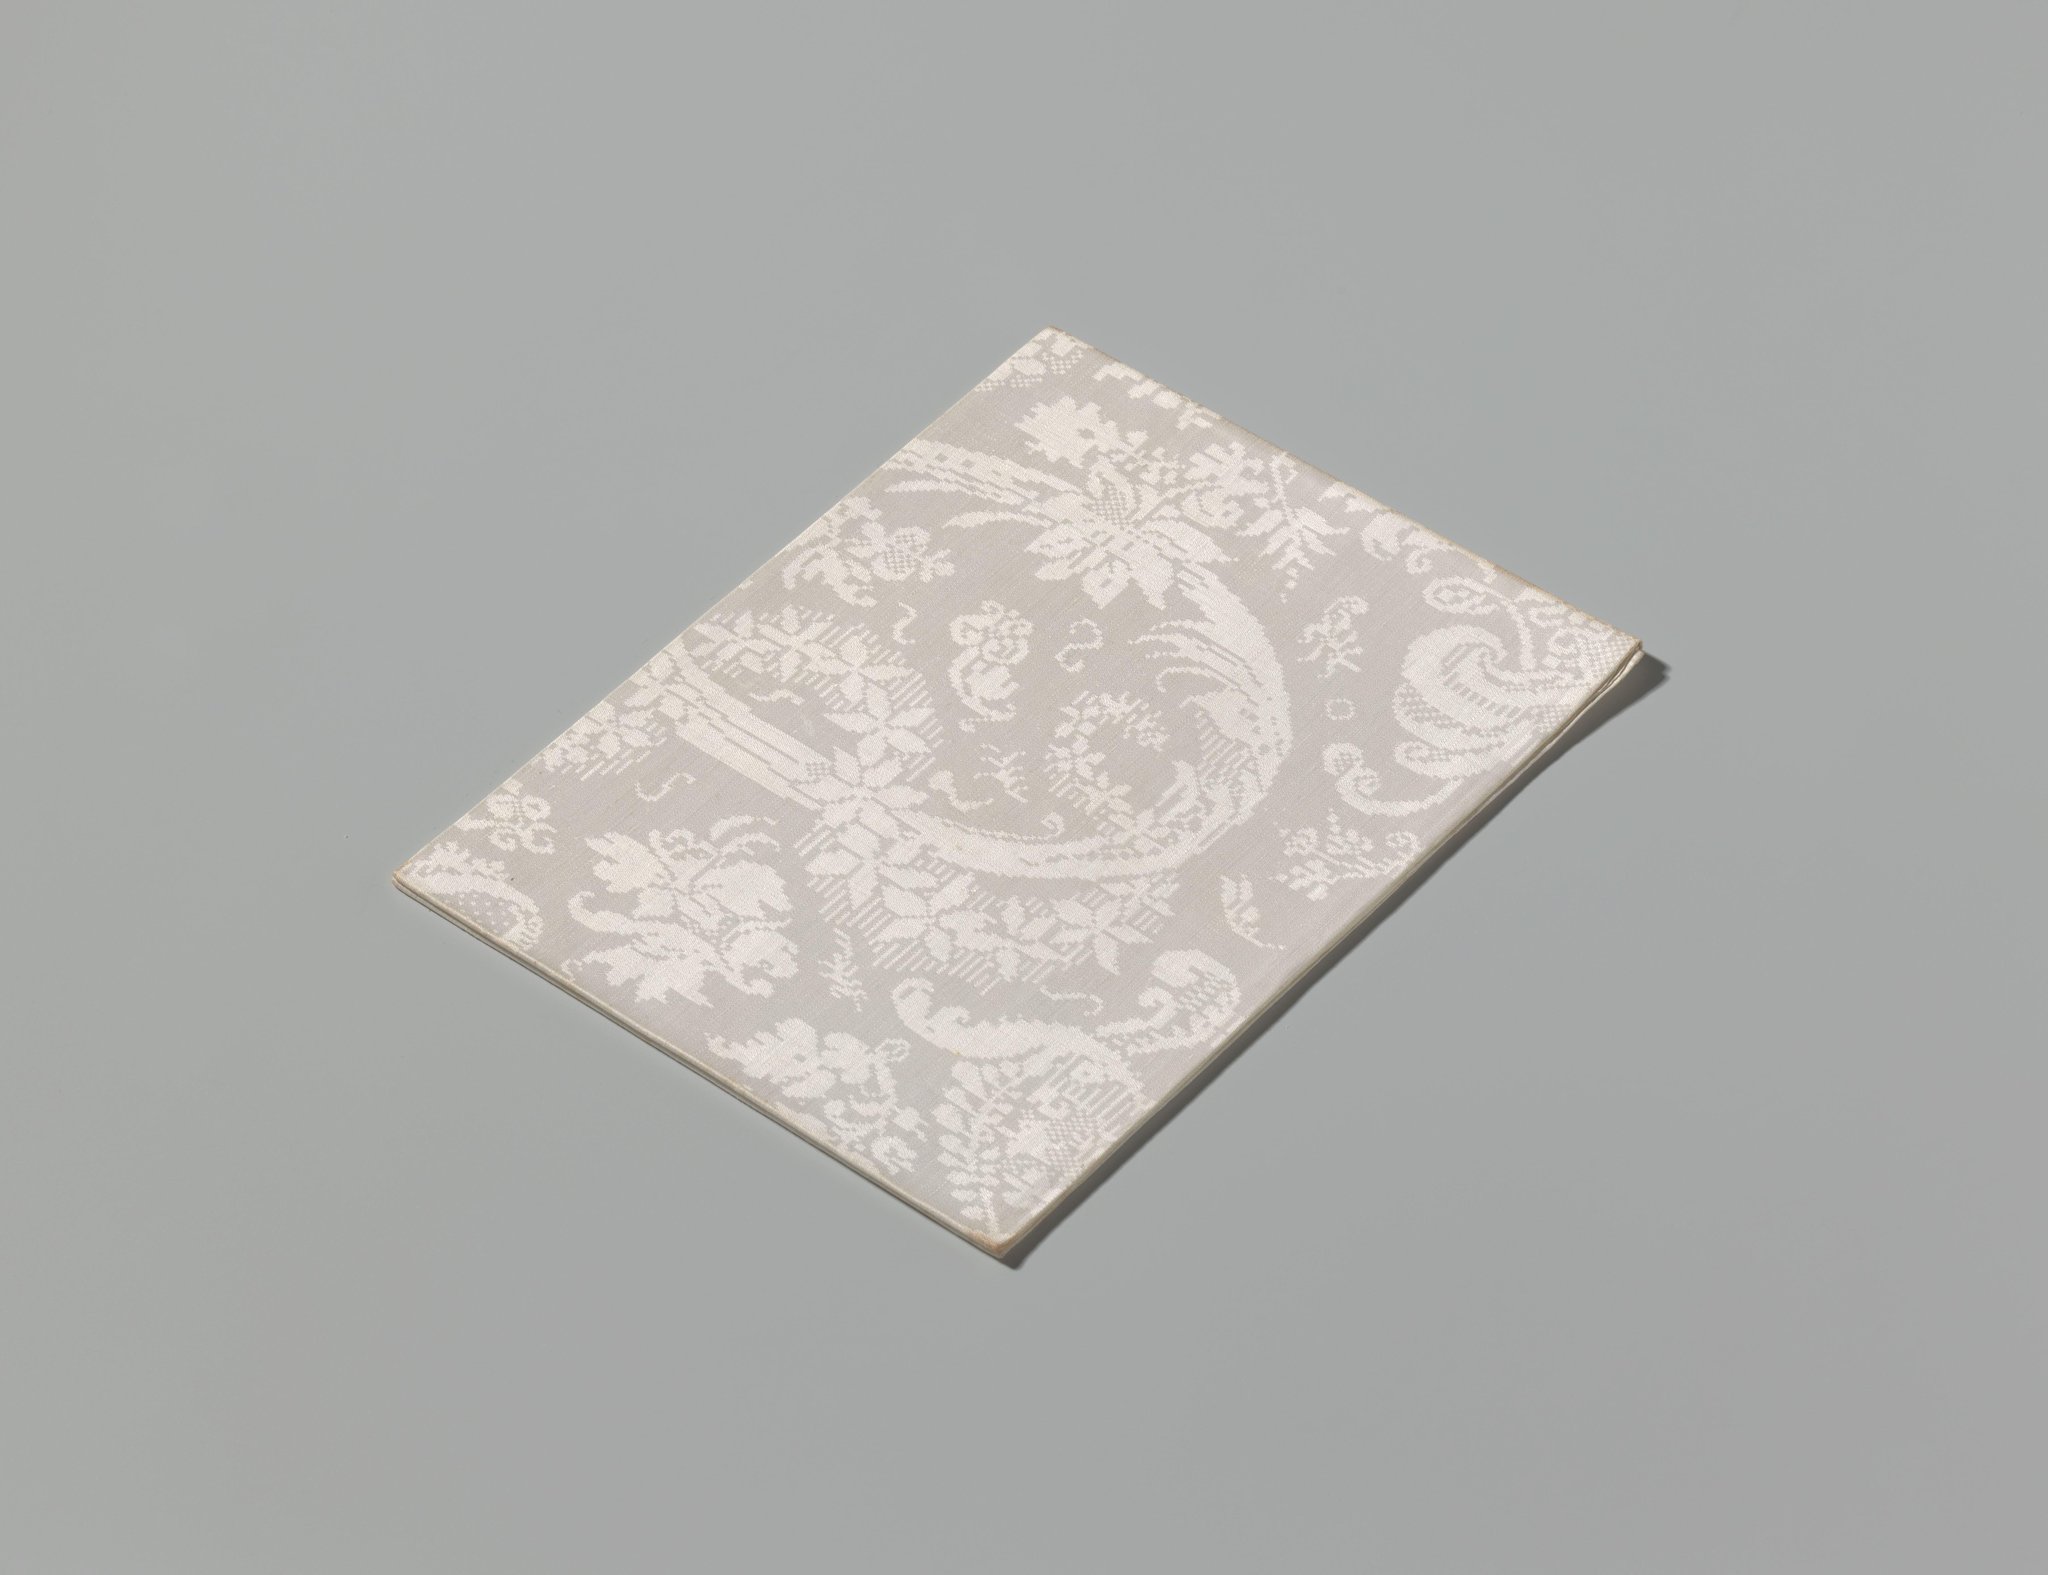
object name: napkin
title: Servet van wit linnendamast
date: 1692-1700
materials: linen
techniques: damask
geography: northern netherlands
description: Wit linnendamasten servet met patroon van voluten, merk IS 24.